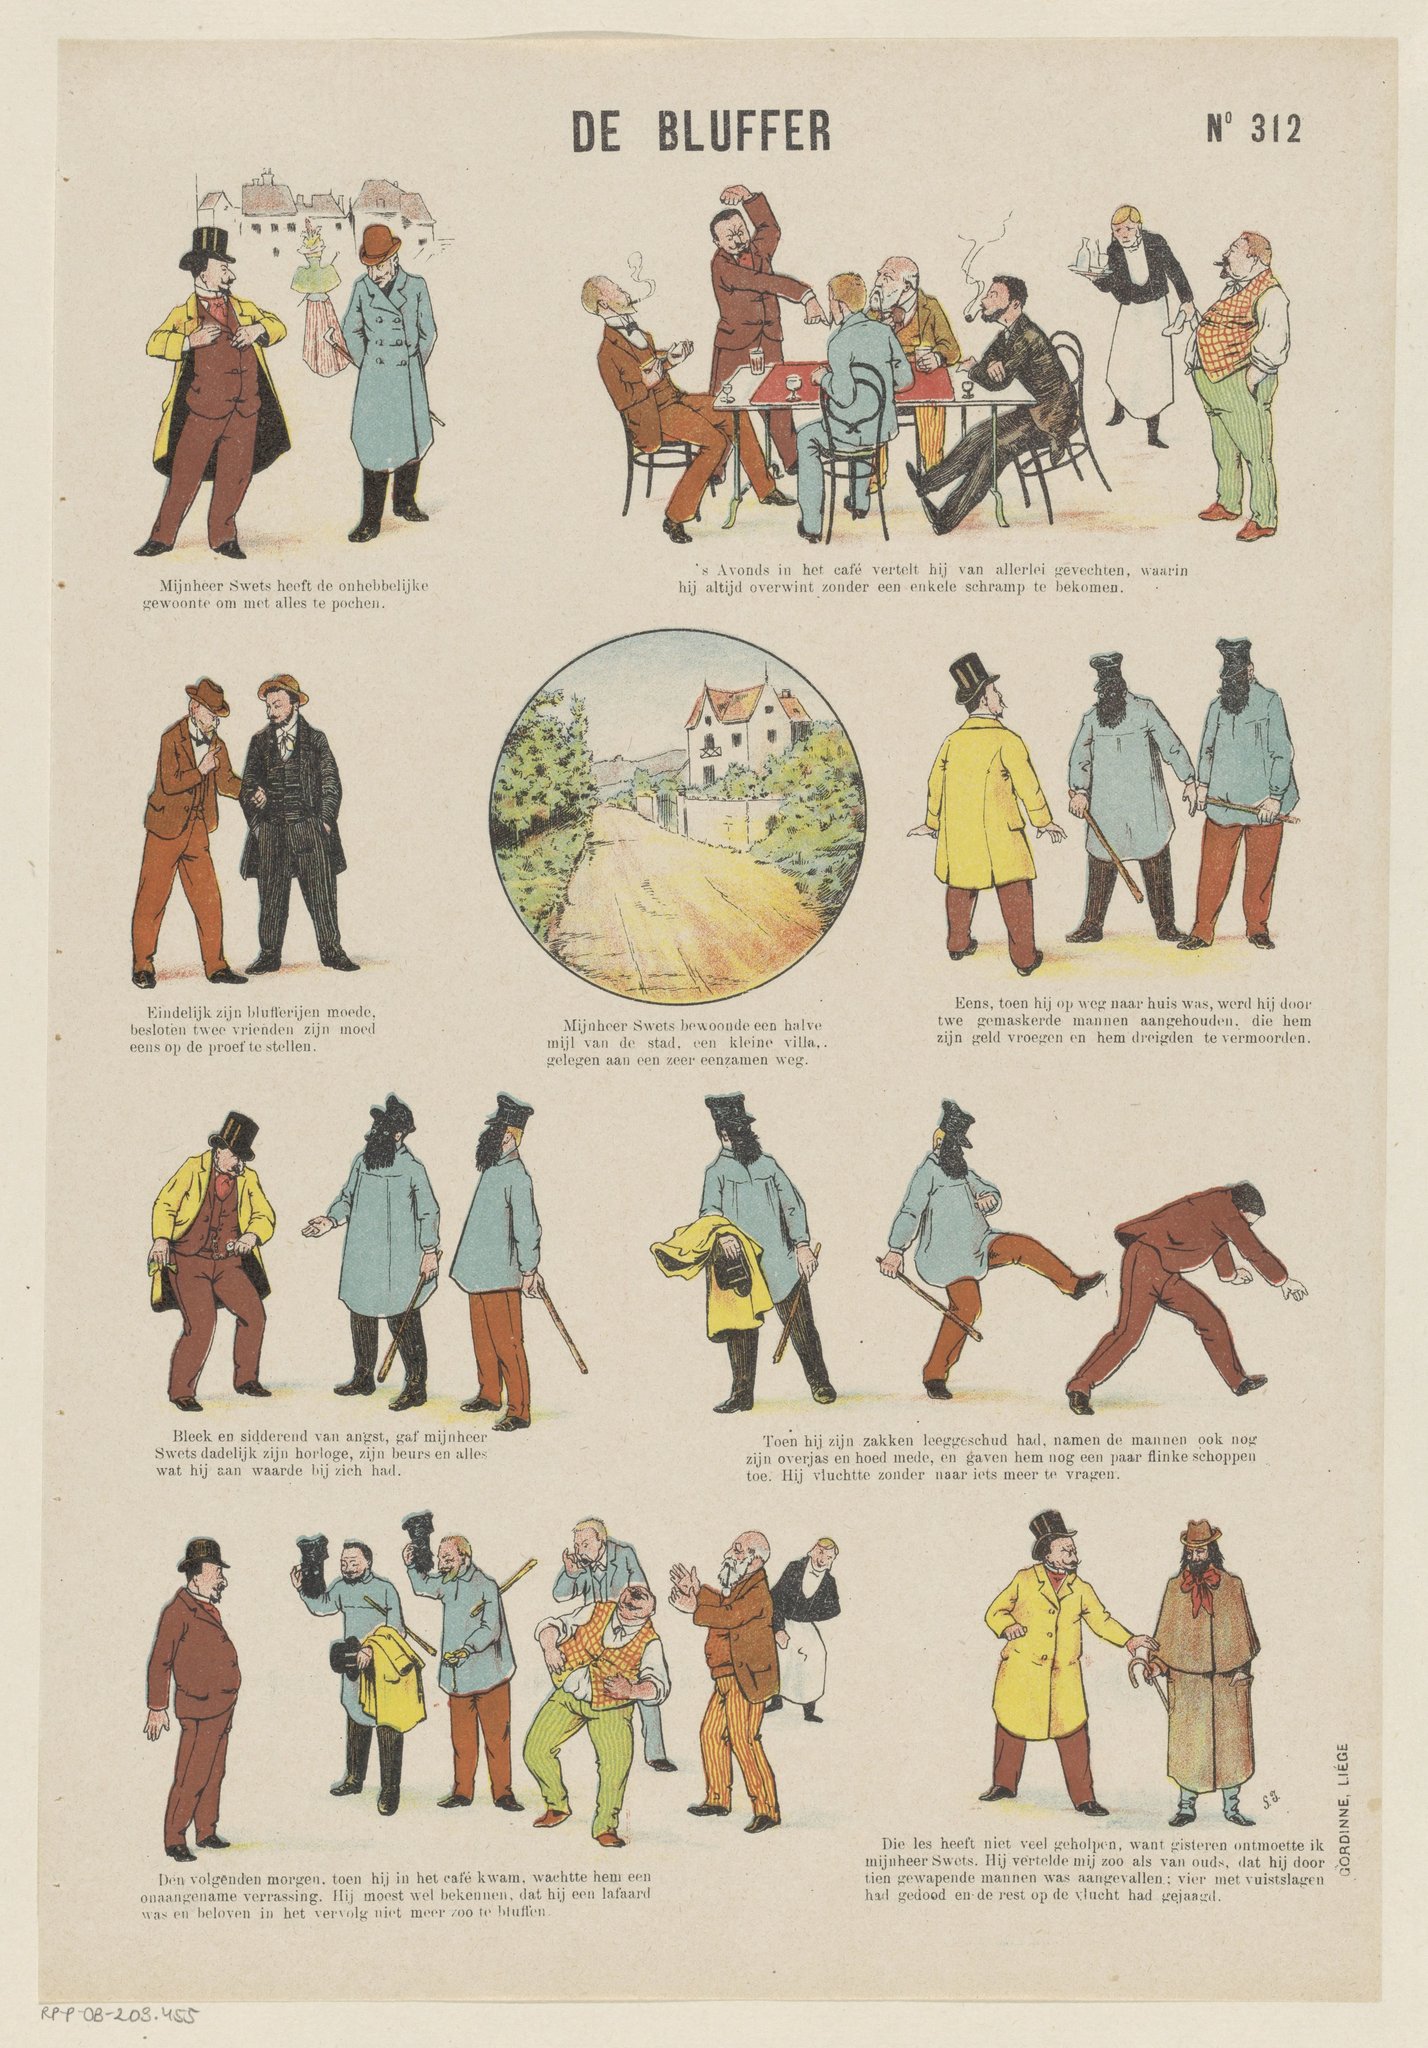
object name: popular print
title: De bluffer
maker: monogrammist g.j.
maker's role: print maker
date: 1894-1959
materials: paper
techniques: lithograph, letterpress printing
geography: liège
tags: weakness, powerlessness, helplessness; 'infermità' (ripa), comedy, courage, bravery, valiance, manliness; 'ardire magnanimo et generoso', 'gagliardezza', 'valore', 'virtù heroica', 'virtù dell'animo e del corpo' (ripa)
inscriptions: collector's mark: Lugt 2760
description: Blad met 9 voorstellingen over Meneer Swets die graag in het café opschept over zijn moed. Zijn vrienden stellen hem op de proef en beroven hem. Onder elke afbeelding een onderschrift. Genummerd rechtsboven: No 312.